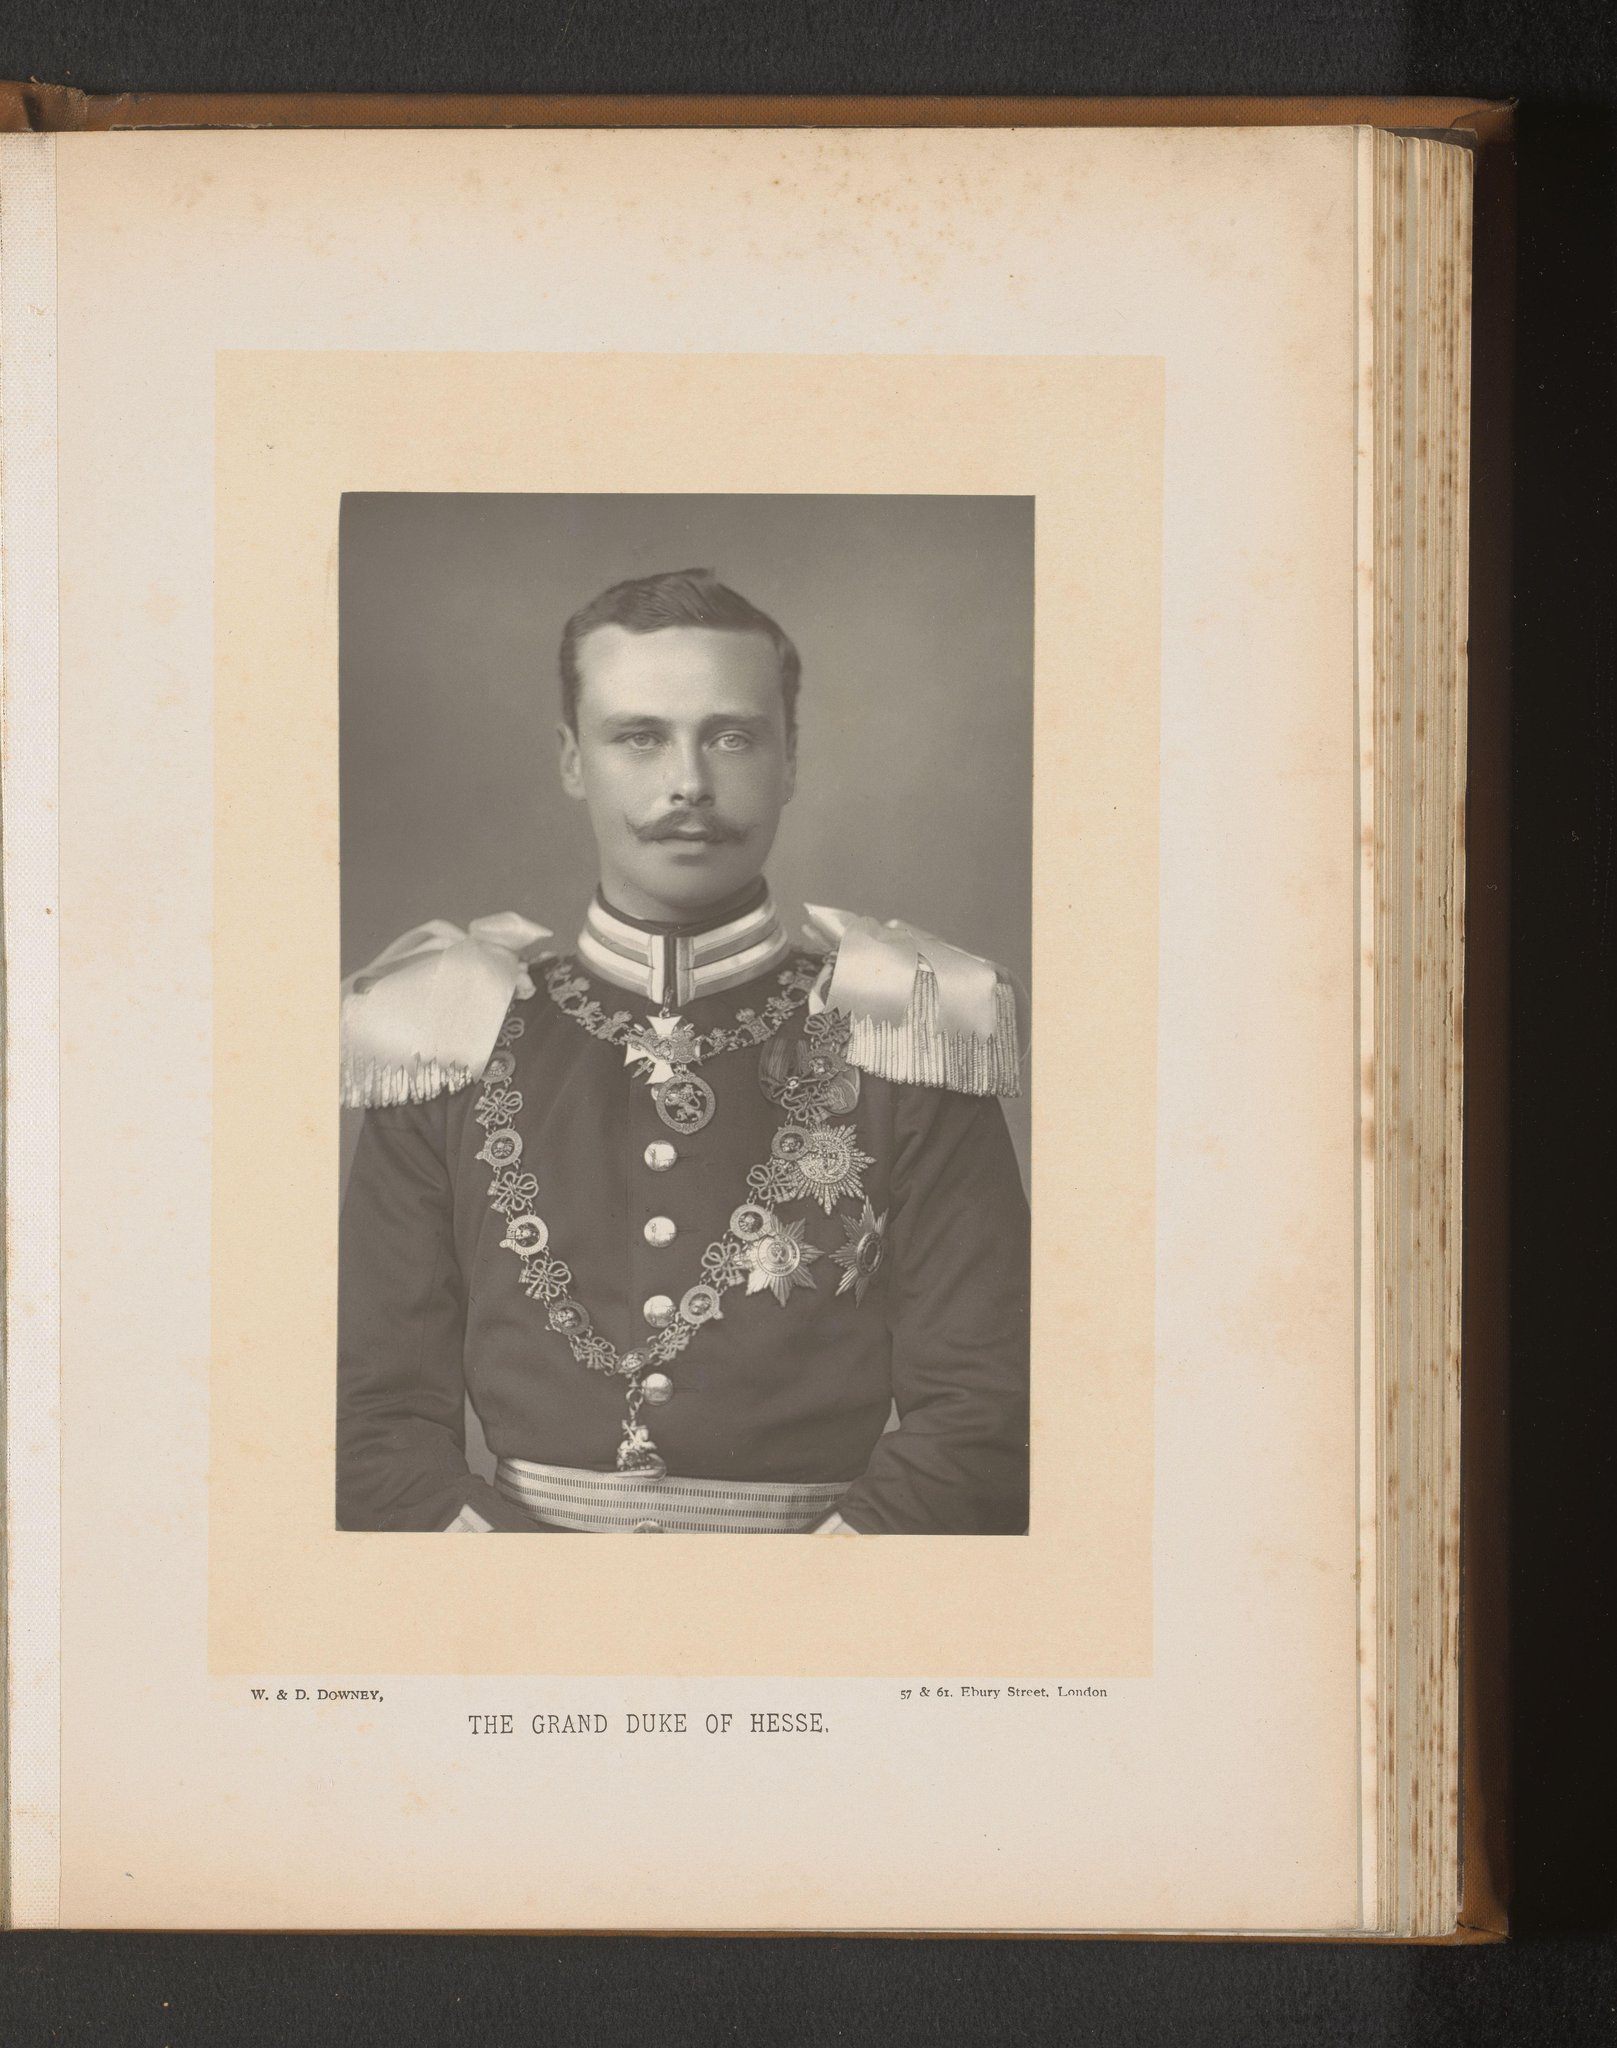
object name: page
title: The grand duke of Hesse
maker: Anonymous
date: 1884-1894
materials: paper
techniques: woodburytype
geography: london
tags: ruler, sovereign, (military) uniforms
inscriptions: inscription: ‘57 & 61, Elbury Street, London.’